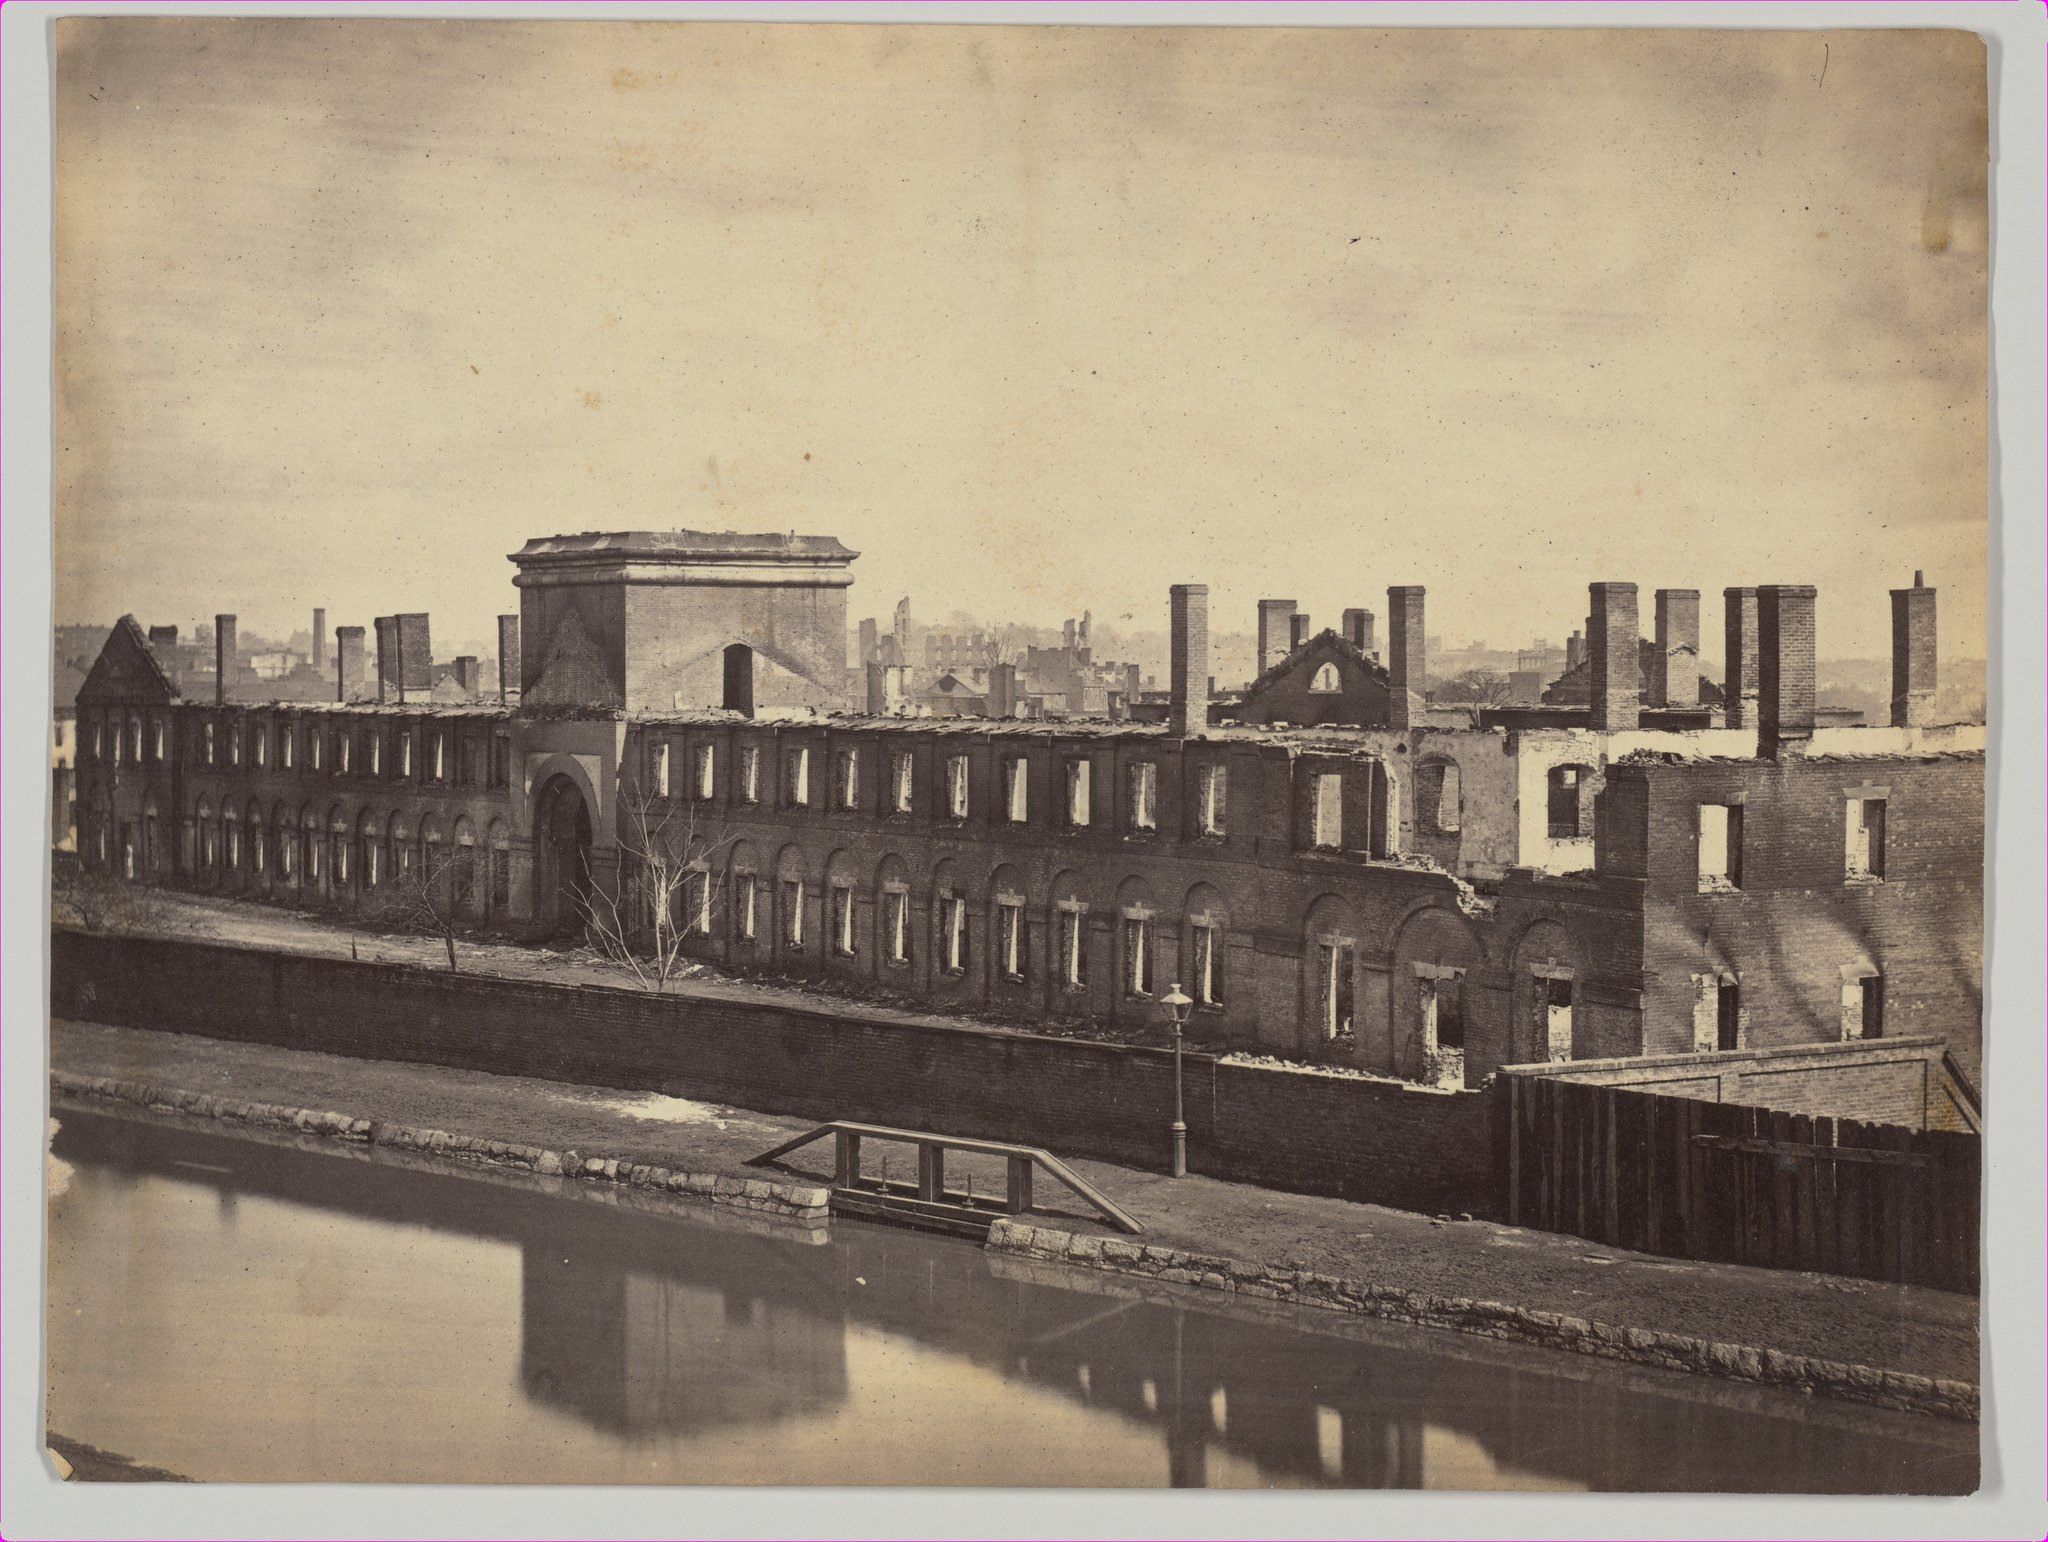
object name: photograph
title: [Ruins of the State Arsenal from the Canal, Richmond, Virginia]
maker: alexander gardner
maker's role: artist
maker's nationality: american, scottish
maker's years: 1821-1882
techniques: albumen silver print, glass negative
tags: american civil war